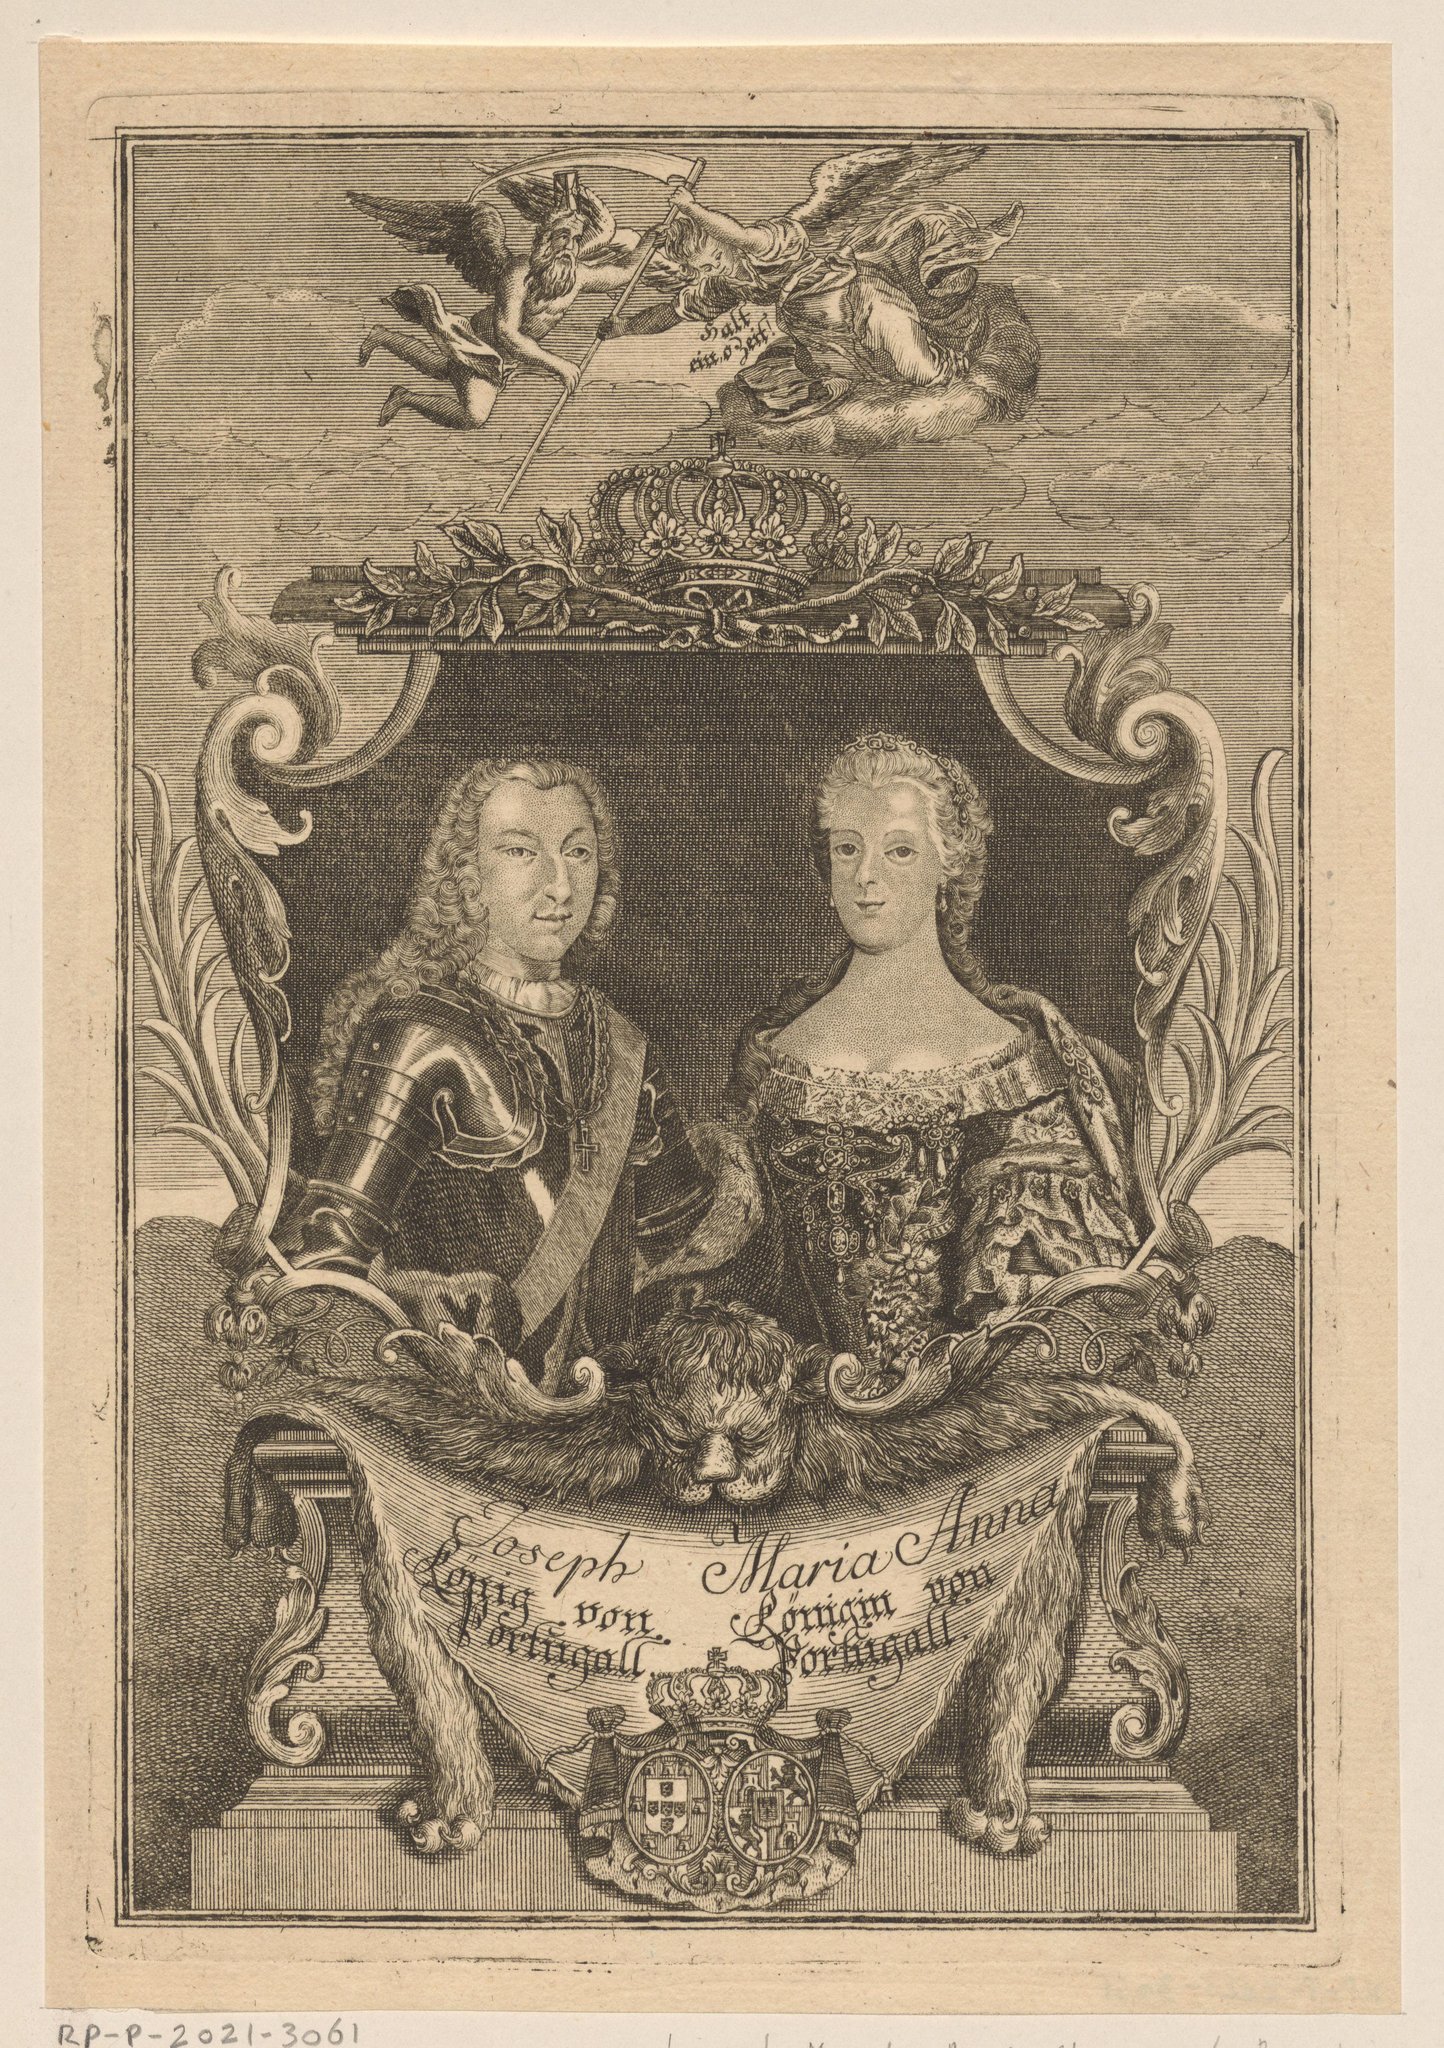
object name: print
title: Portret van Jozef I, koning van Portugal en Maria Anna van Oostenrijk, koningin van Portugal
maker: Anonymous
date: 1750-1799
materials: paper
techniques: engraving, etching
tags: attributes of hercules (with name), crown (symbol of sovereignty), historical persons, king, armorial bearing, heraldry